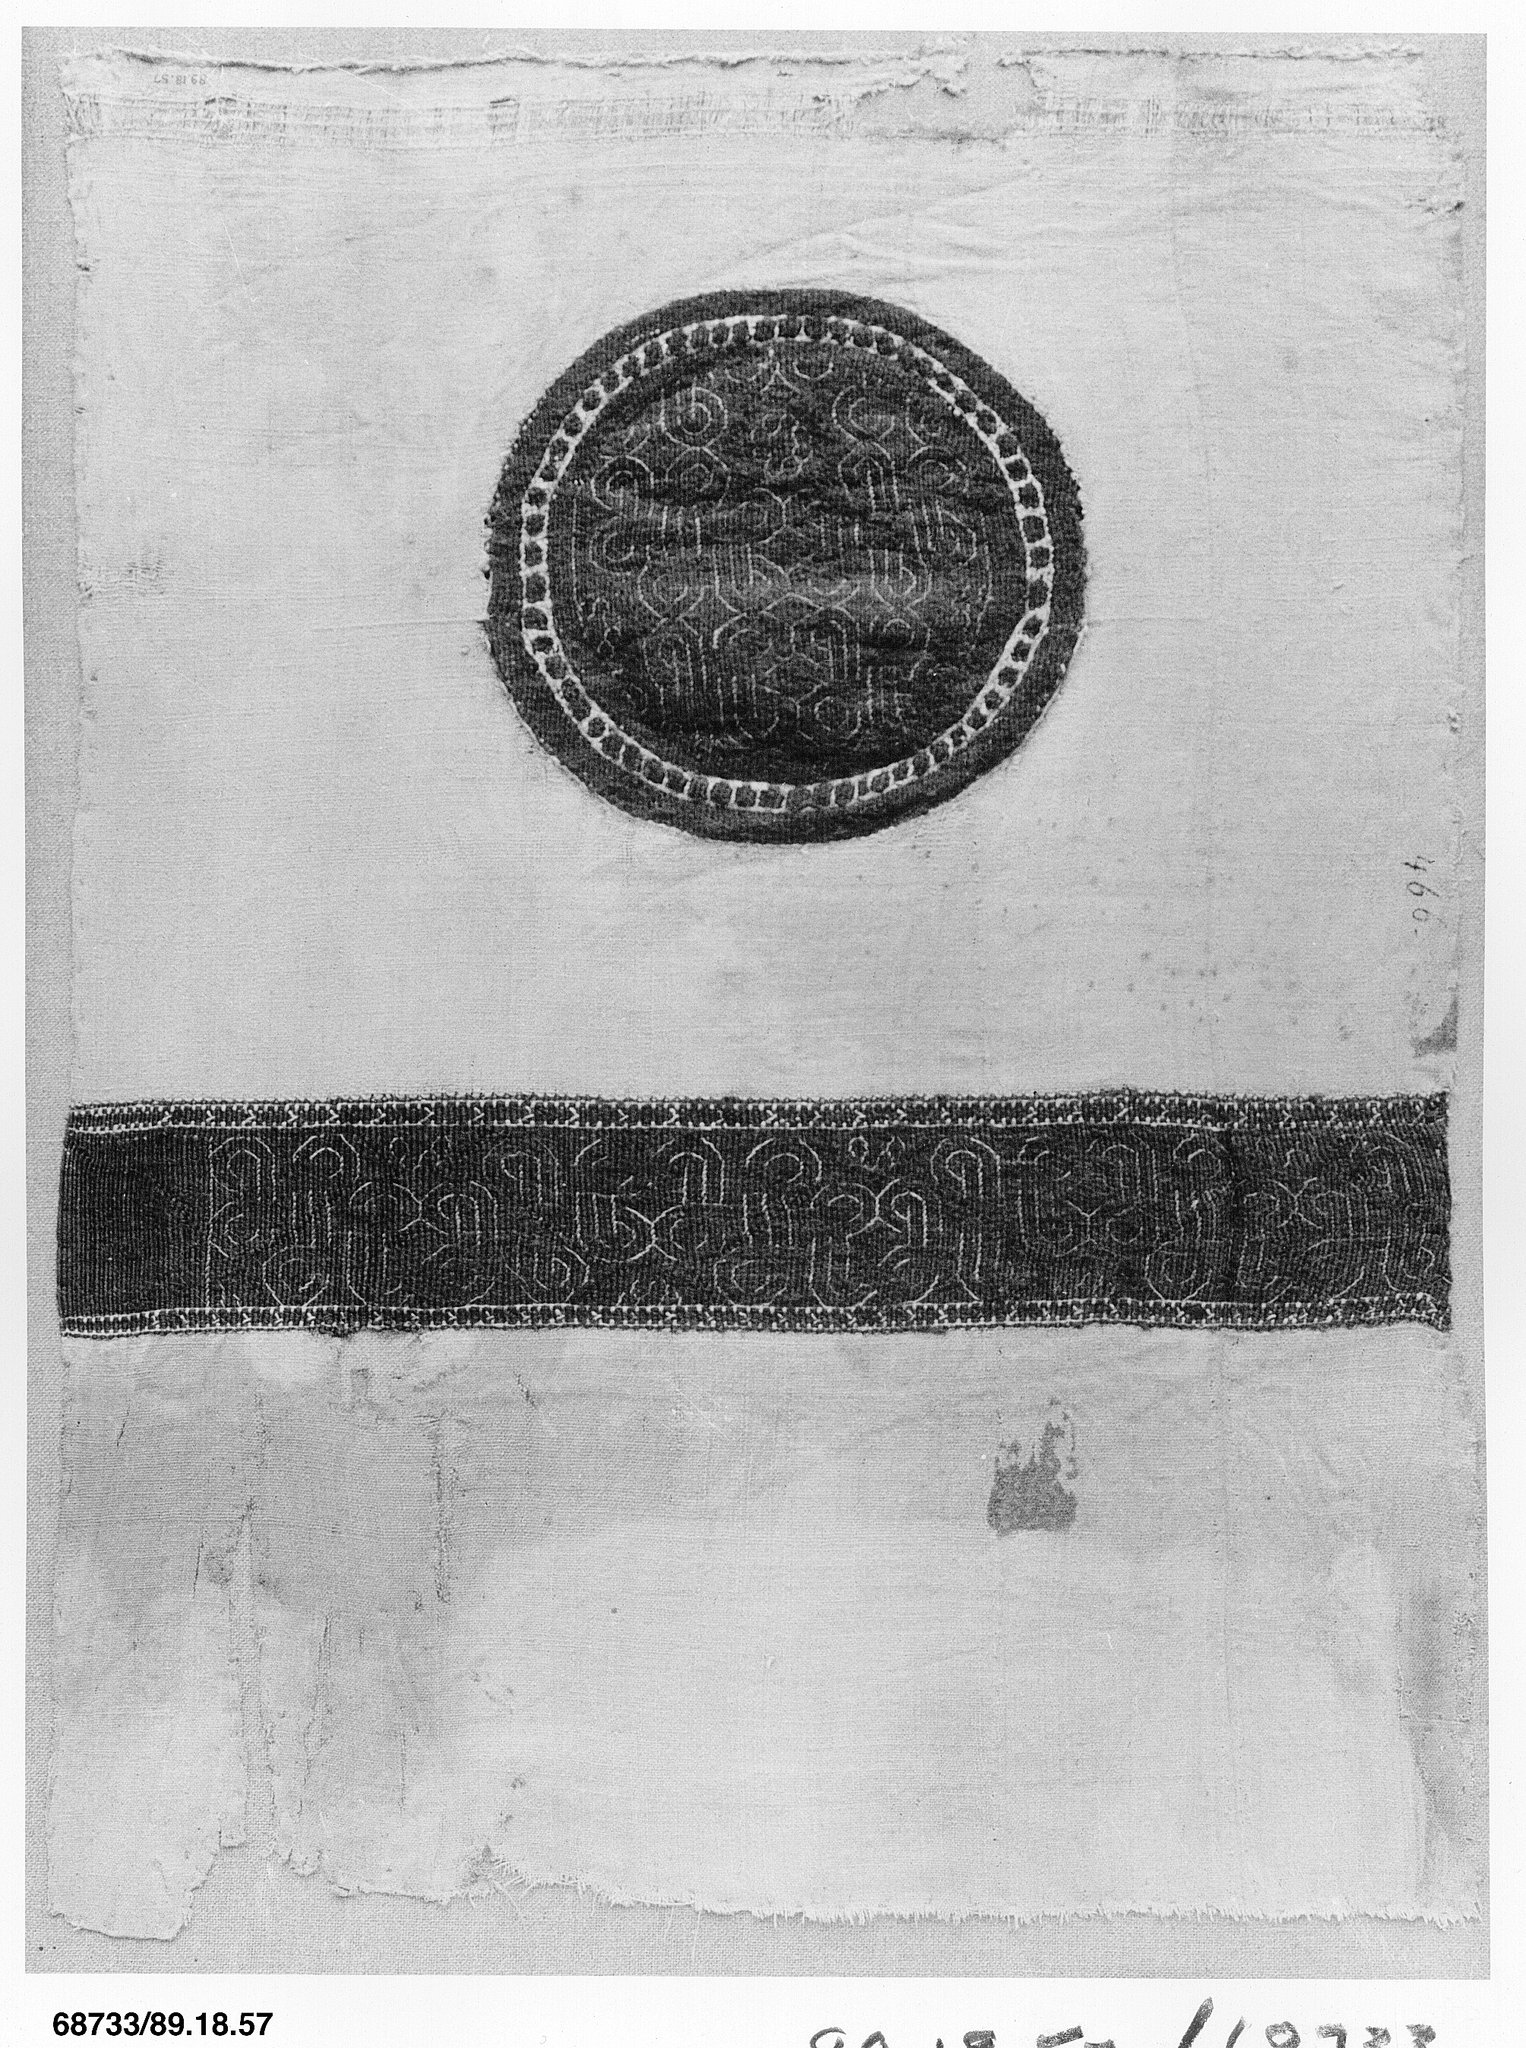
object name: textile fragment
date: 201-400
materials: linen, wool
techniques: weave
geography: egypt